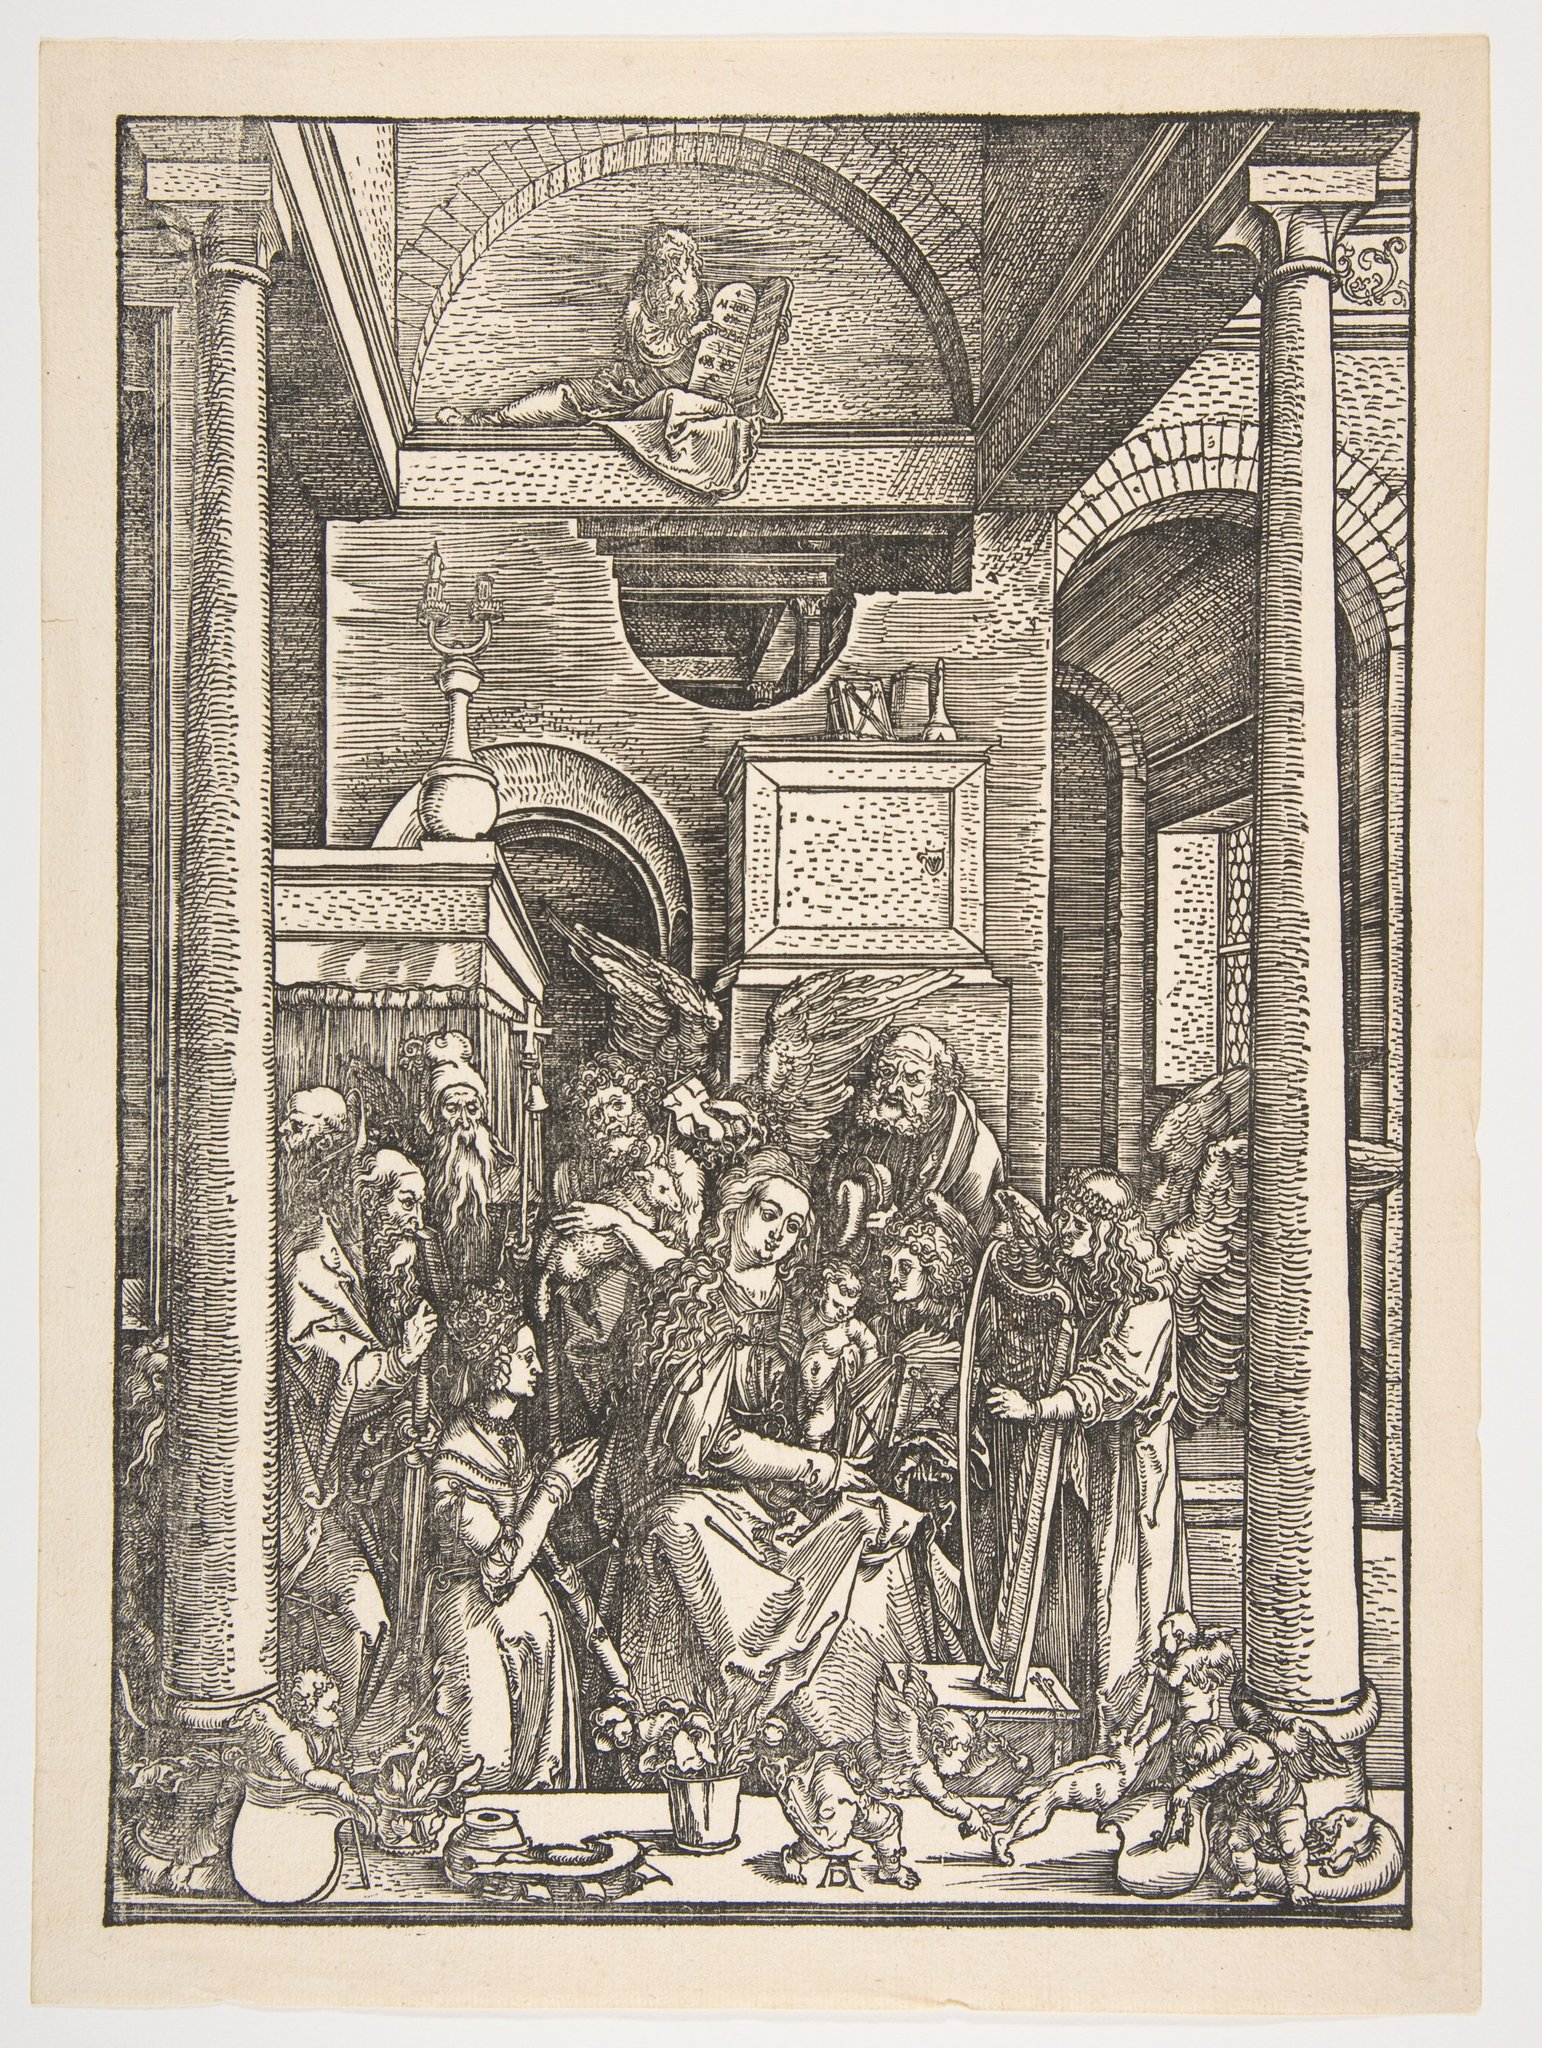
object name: print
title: The Glorification of the Virgin, from "The Life of The Virgin"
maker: albrecht dürer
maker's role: artist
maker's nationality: german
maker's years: 1471-1528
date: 1502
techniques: woodcut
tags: angels,virgin mary,jesus